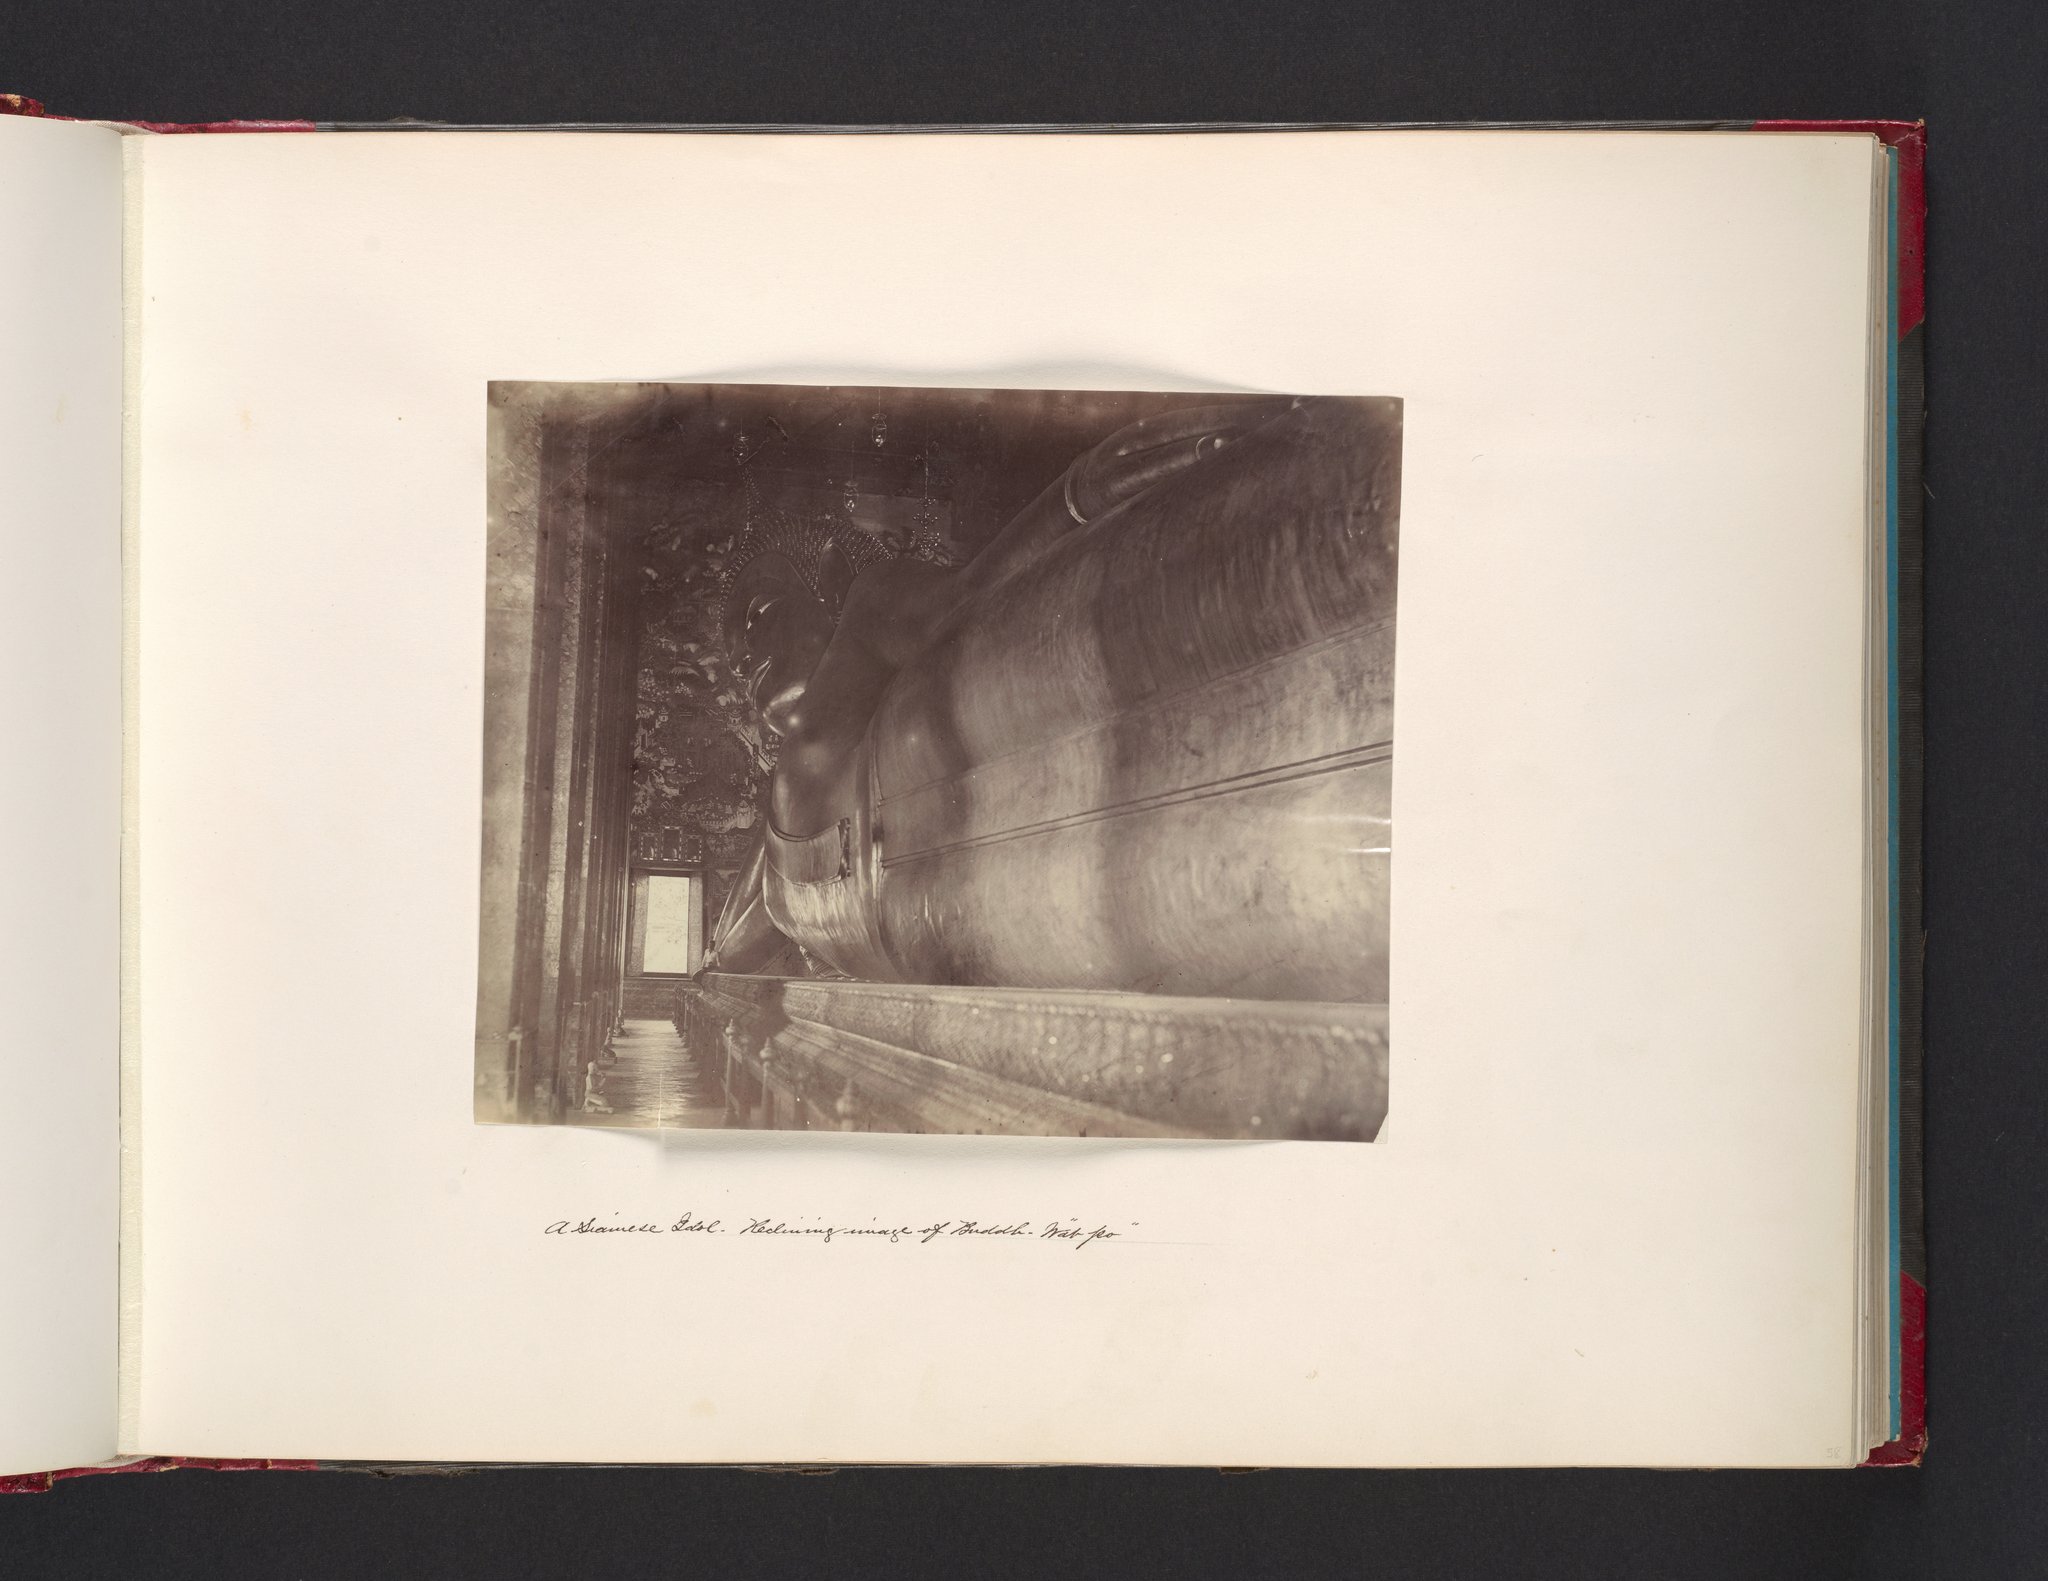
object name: photograph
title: A Siamese Idol - Reclining Image of Buddah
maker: john thomson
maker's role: artist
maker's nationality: british, scottish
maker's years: 1837-1921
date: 1865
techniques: albumen silver print, glass negative